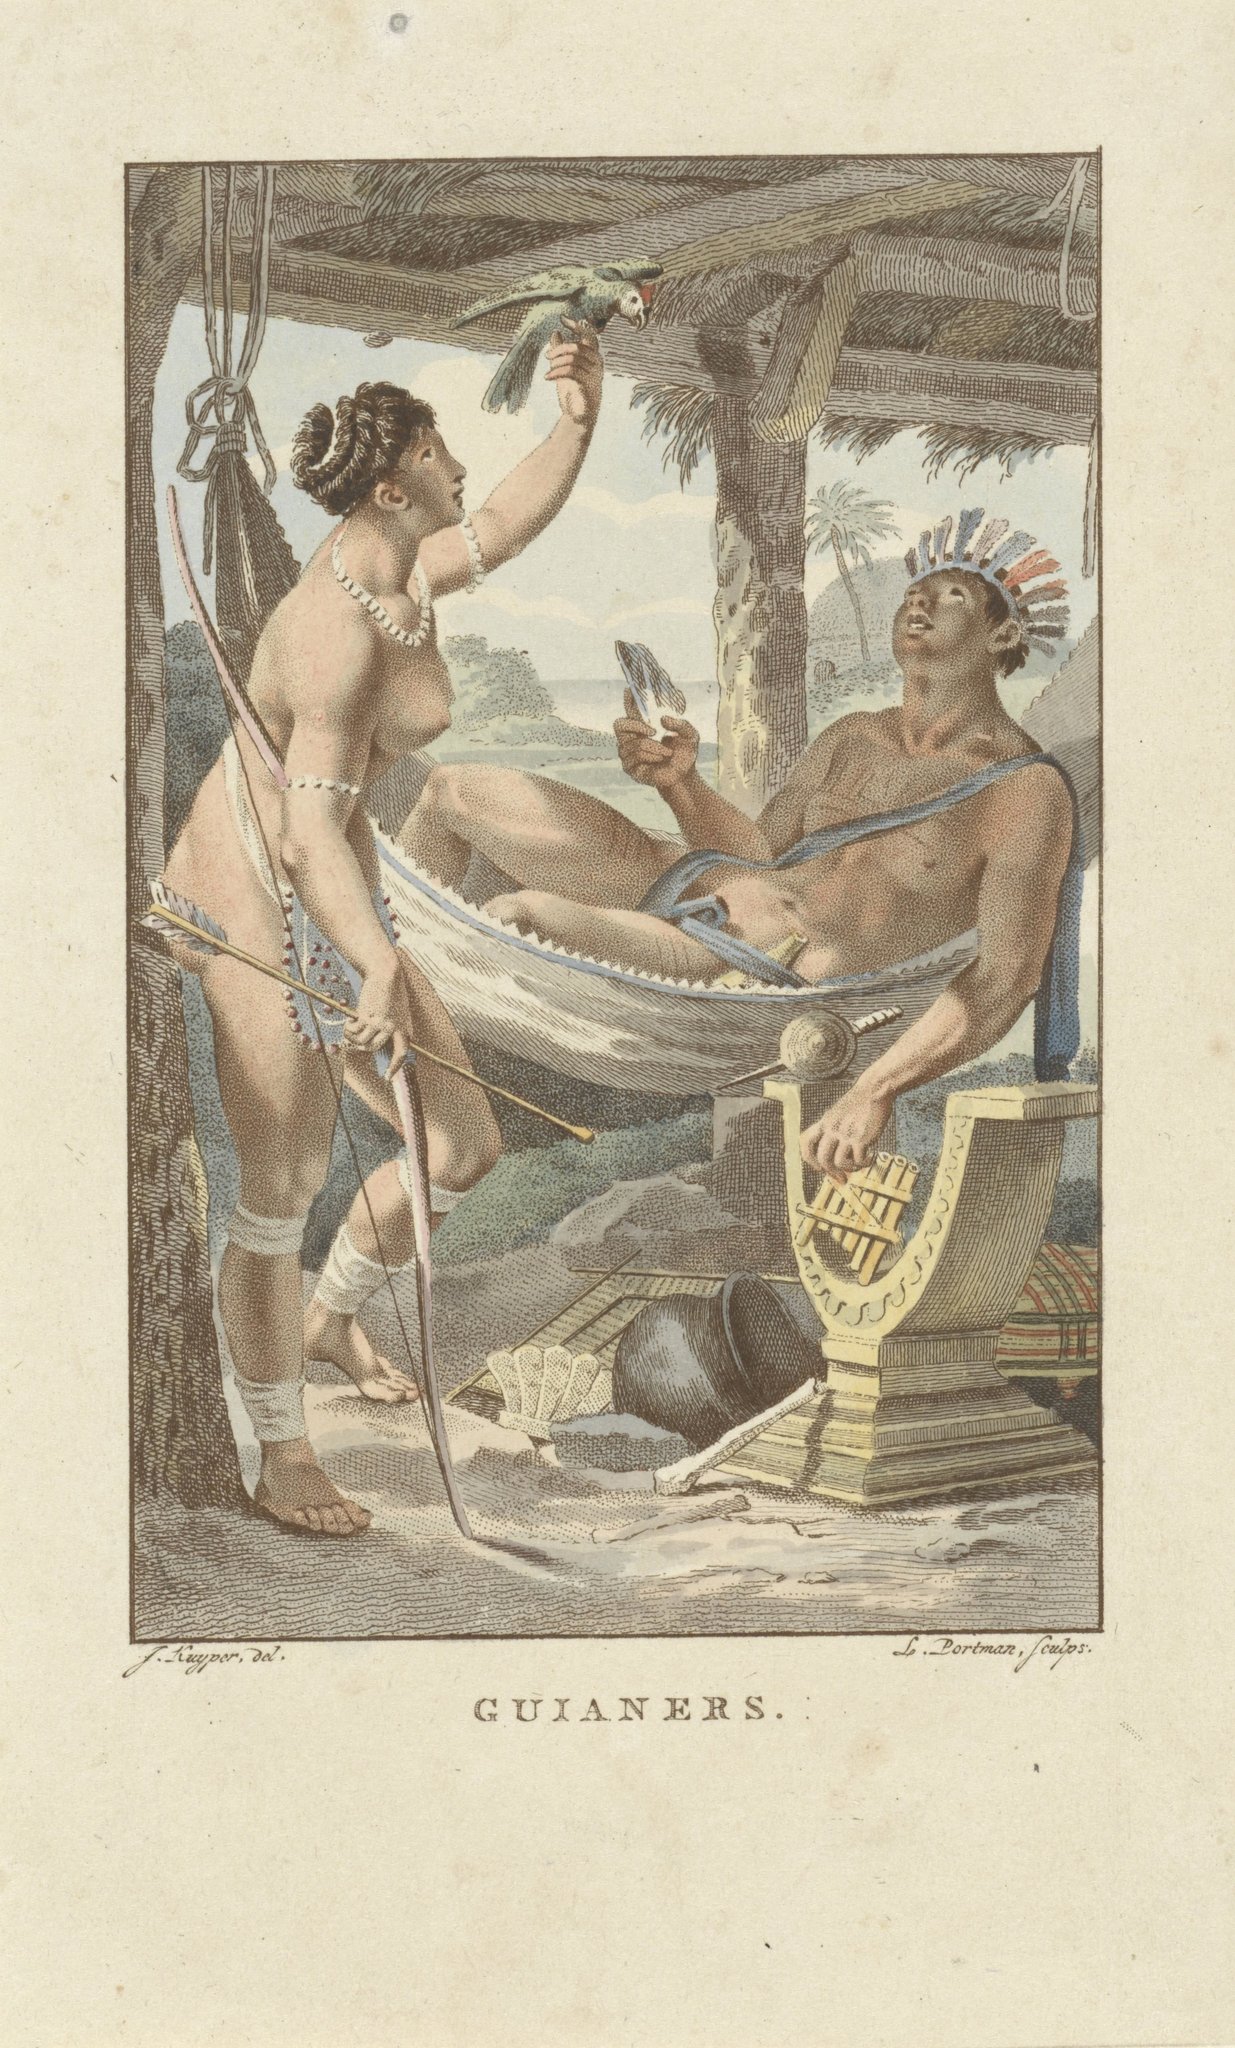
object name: print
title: Bewoners van Guyana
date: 1805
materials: paper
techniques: etching, hand coloring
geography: amsterdam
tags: hammock, ornamental birds: parrot (+ man and animal), human races; peoples; nationalities (+ costume)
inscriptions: collector's mark: Lugt 2760, collector's mark: Lugt 2166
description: Een man ligt onder een afdak in een hangmat. In zijn handen heeft hij een stuk spiegel en een fluit. Zijn vrouw biedt hem de papegaai aan die ze zojuist geschoten heeft.